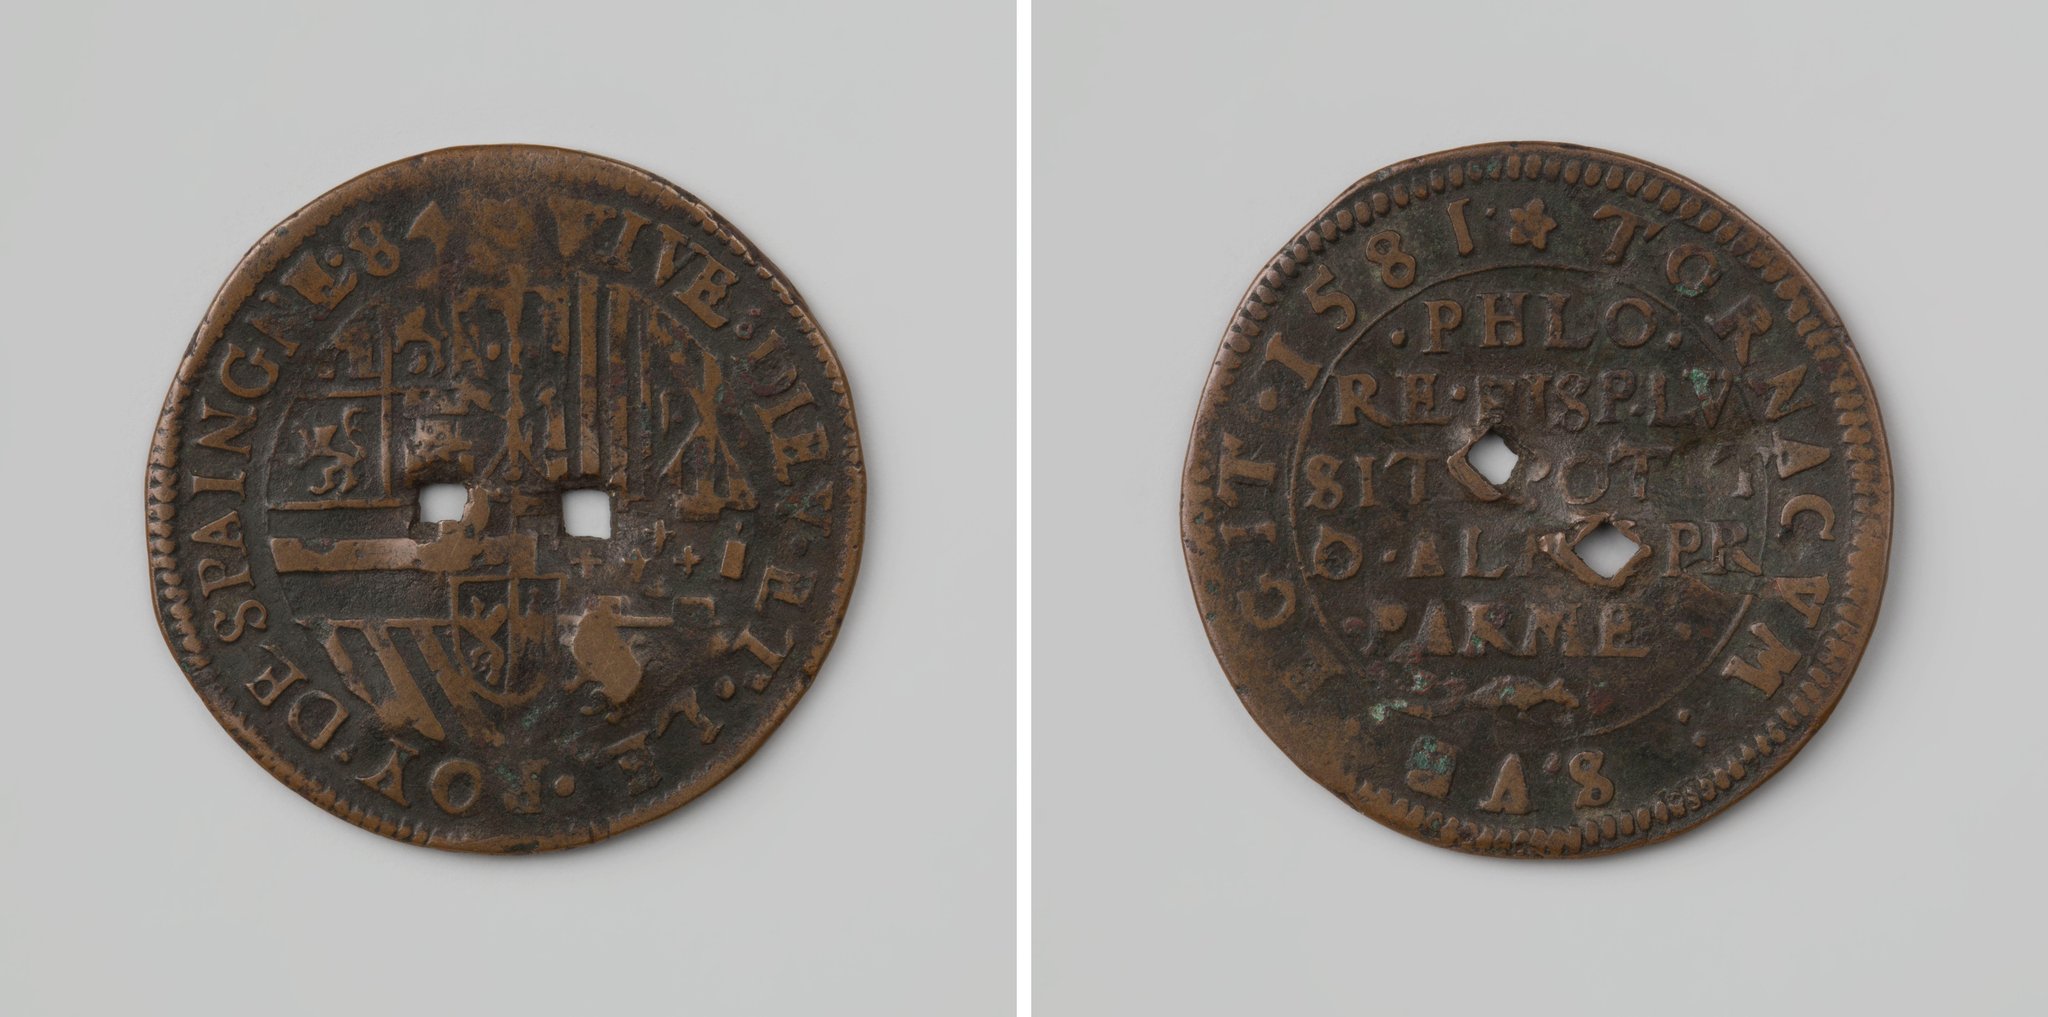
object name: jeton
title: Verovering van Portugal en inname van Doornik door Alessandro Farnese, prins van Parma en Piacenza benoemd, landvoogd der Nederlanden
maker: Anonymous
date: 1581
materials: copper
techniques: striking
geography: arras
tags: philip ii of spain, vienna, albert casimir van saksen-teschen, rome, alessandro farnese (landvoogd van de nederlanden en hertog van parma en piacenza)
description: Koperen penning met twee rechthoekige gaten erin. Voorzijde: wapenschild binnen omschrift. Keerzijde: opschrift boven muisje binnen omschrift